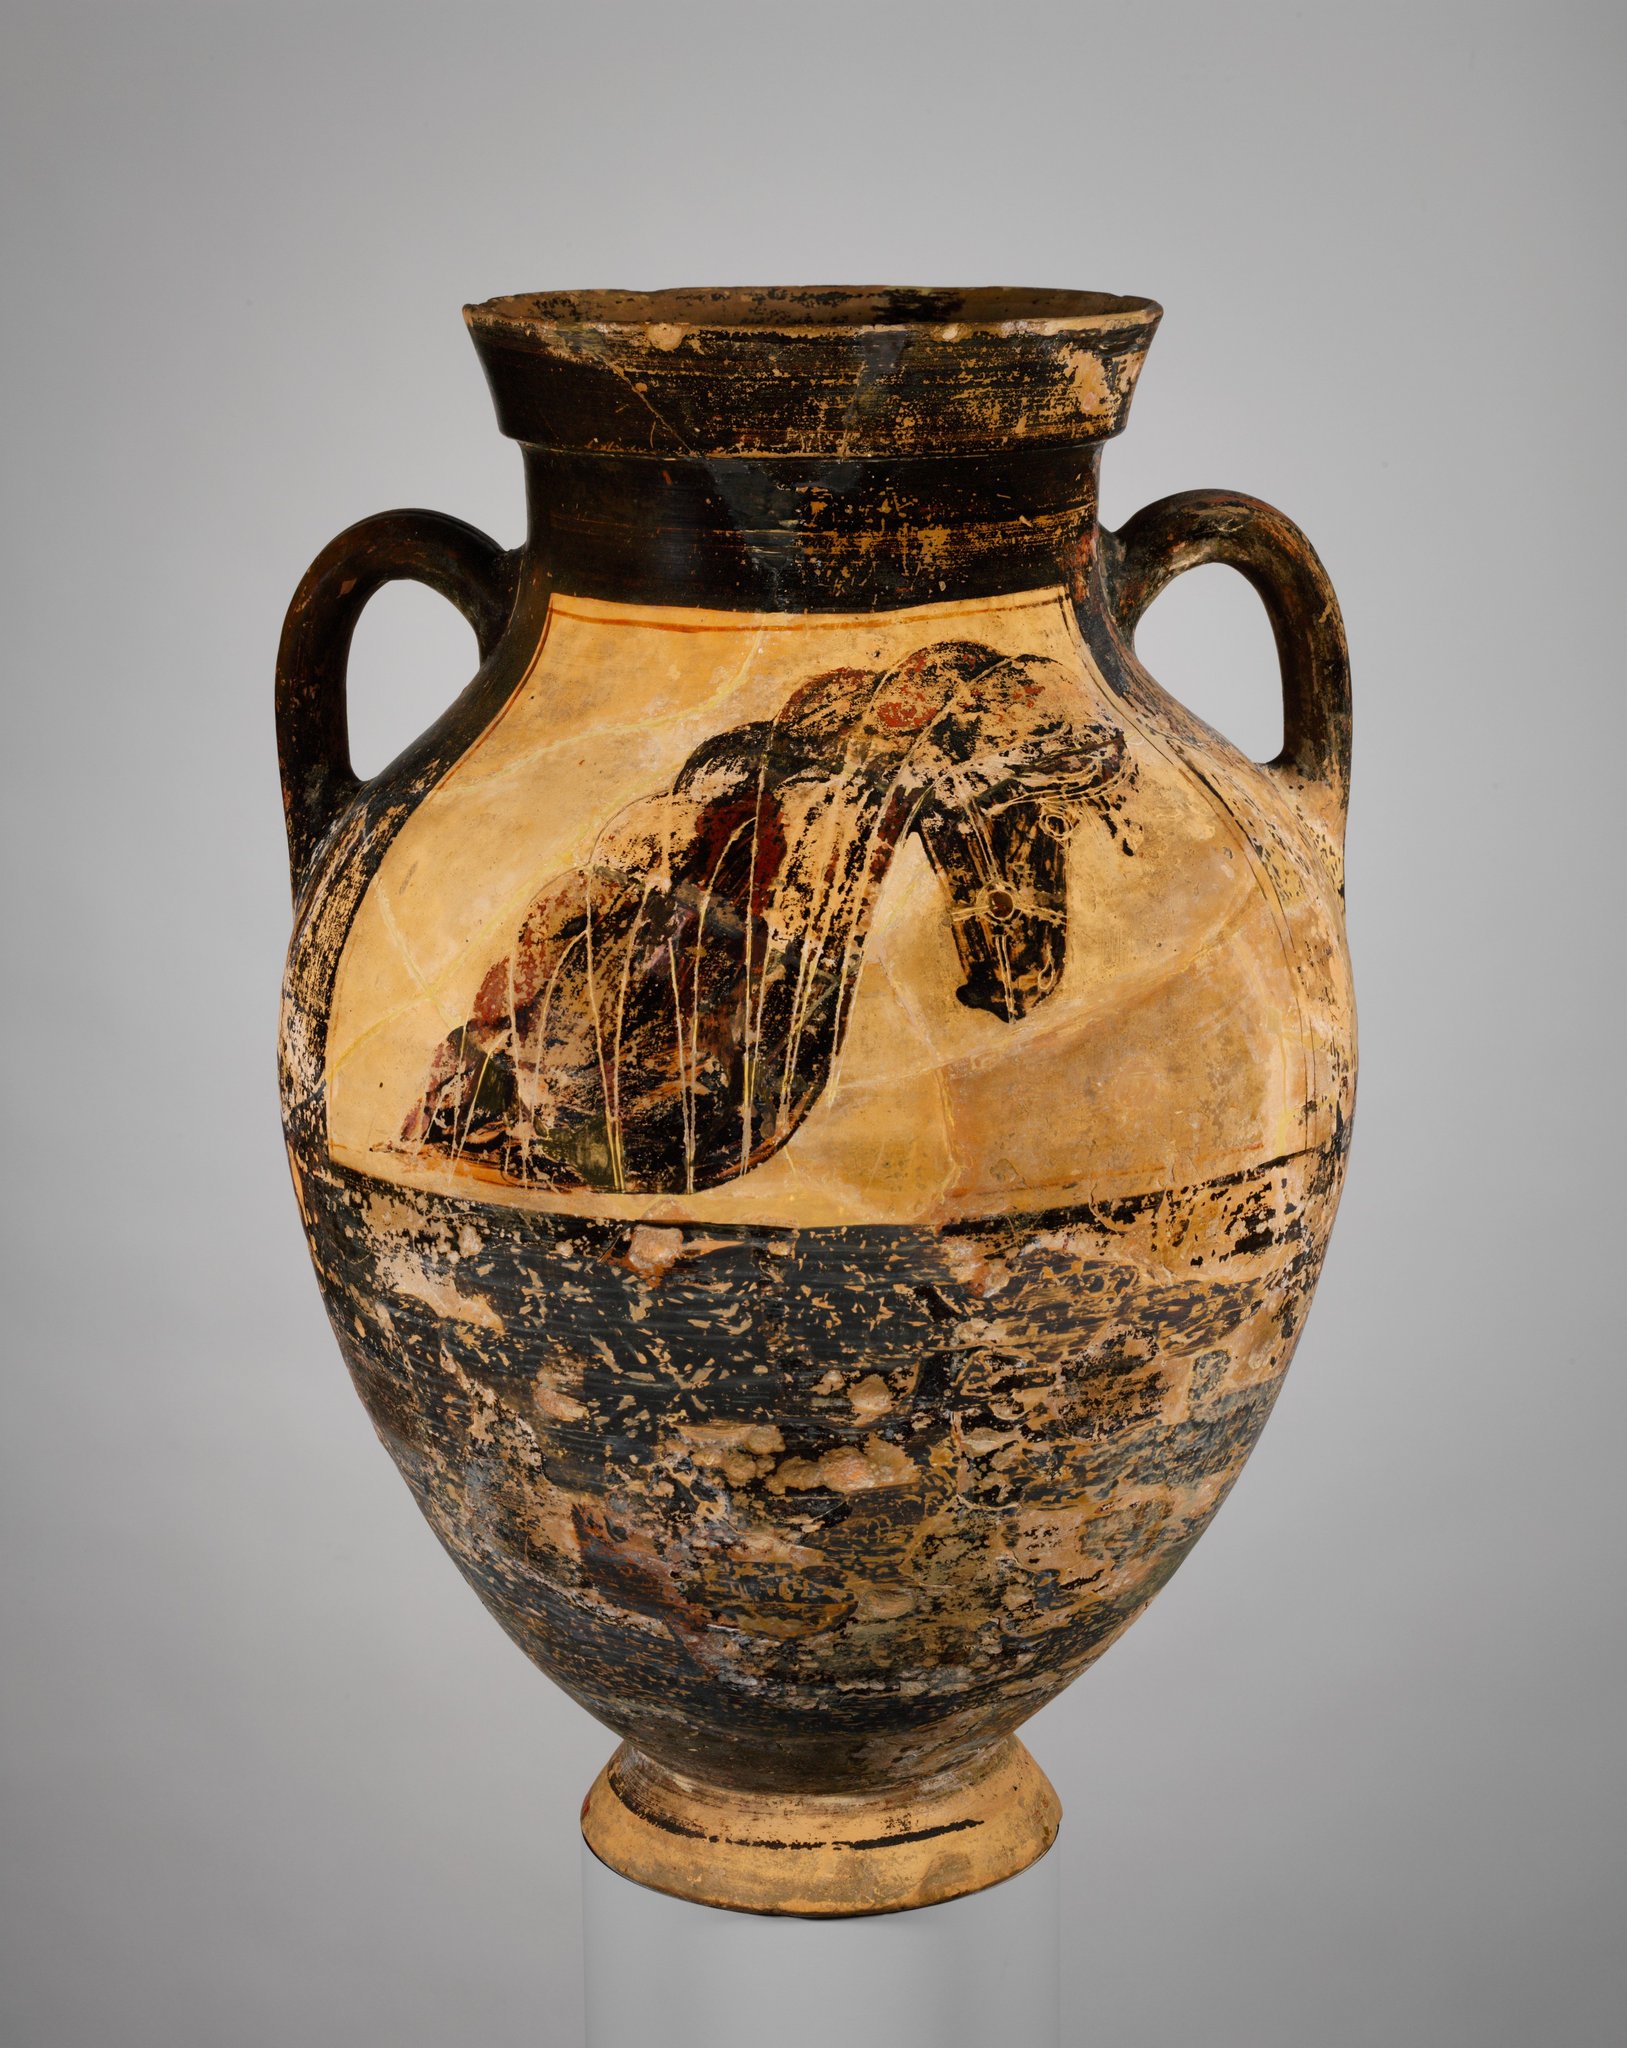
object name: amphora, type b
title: Terracotta amphora (jar)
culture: greek, attic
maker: the horse-head amphorae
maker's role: artist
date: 600 BCE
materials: terracotta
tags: horses